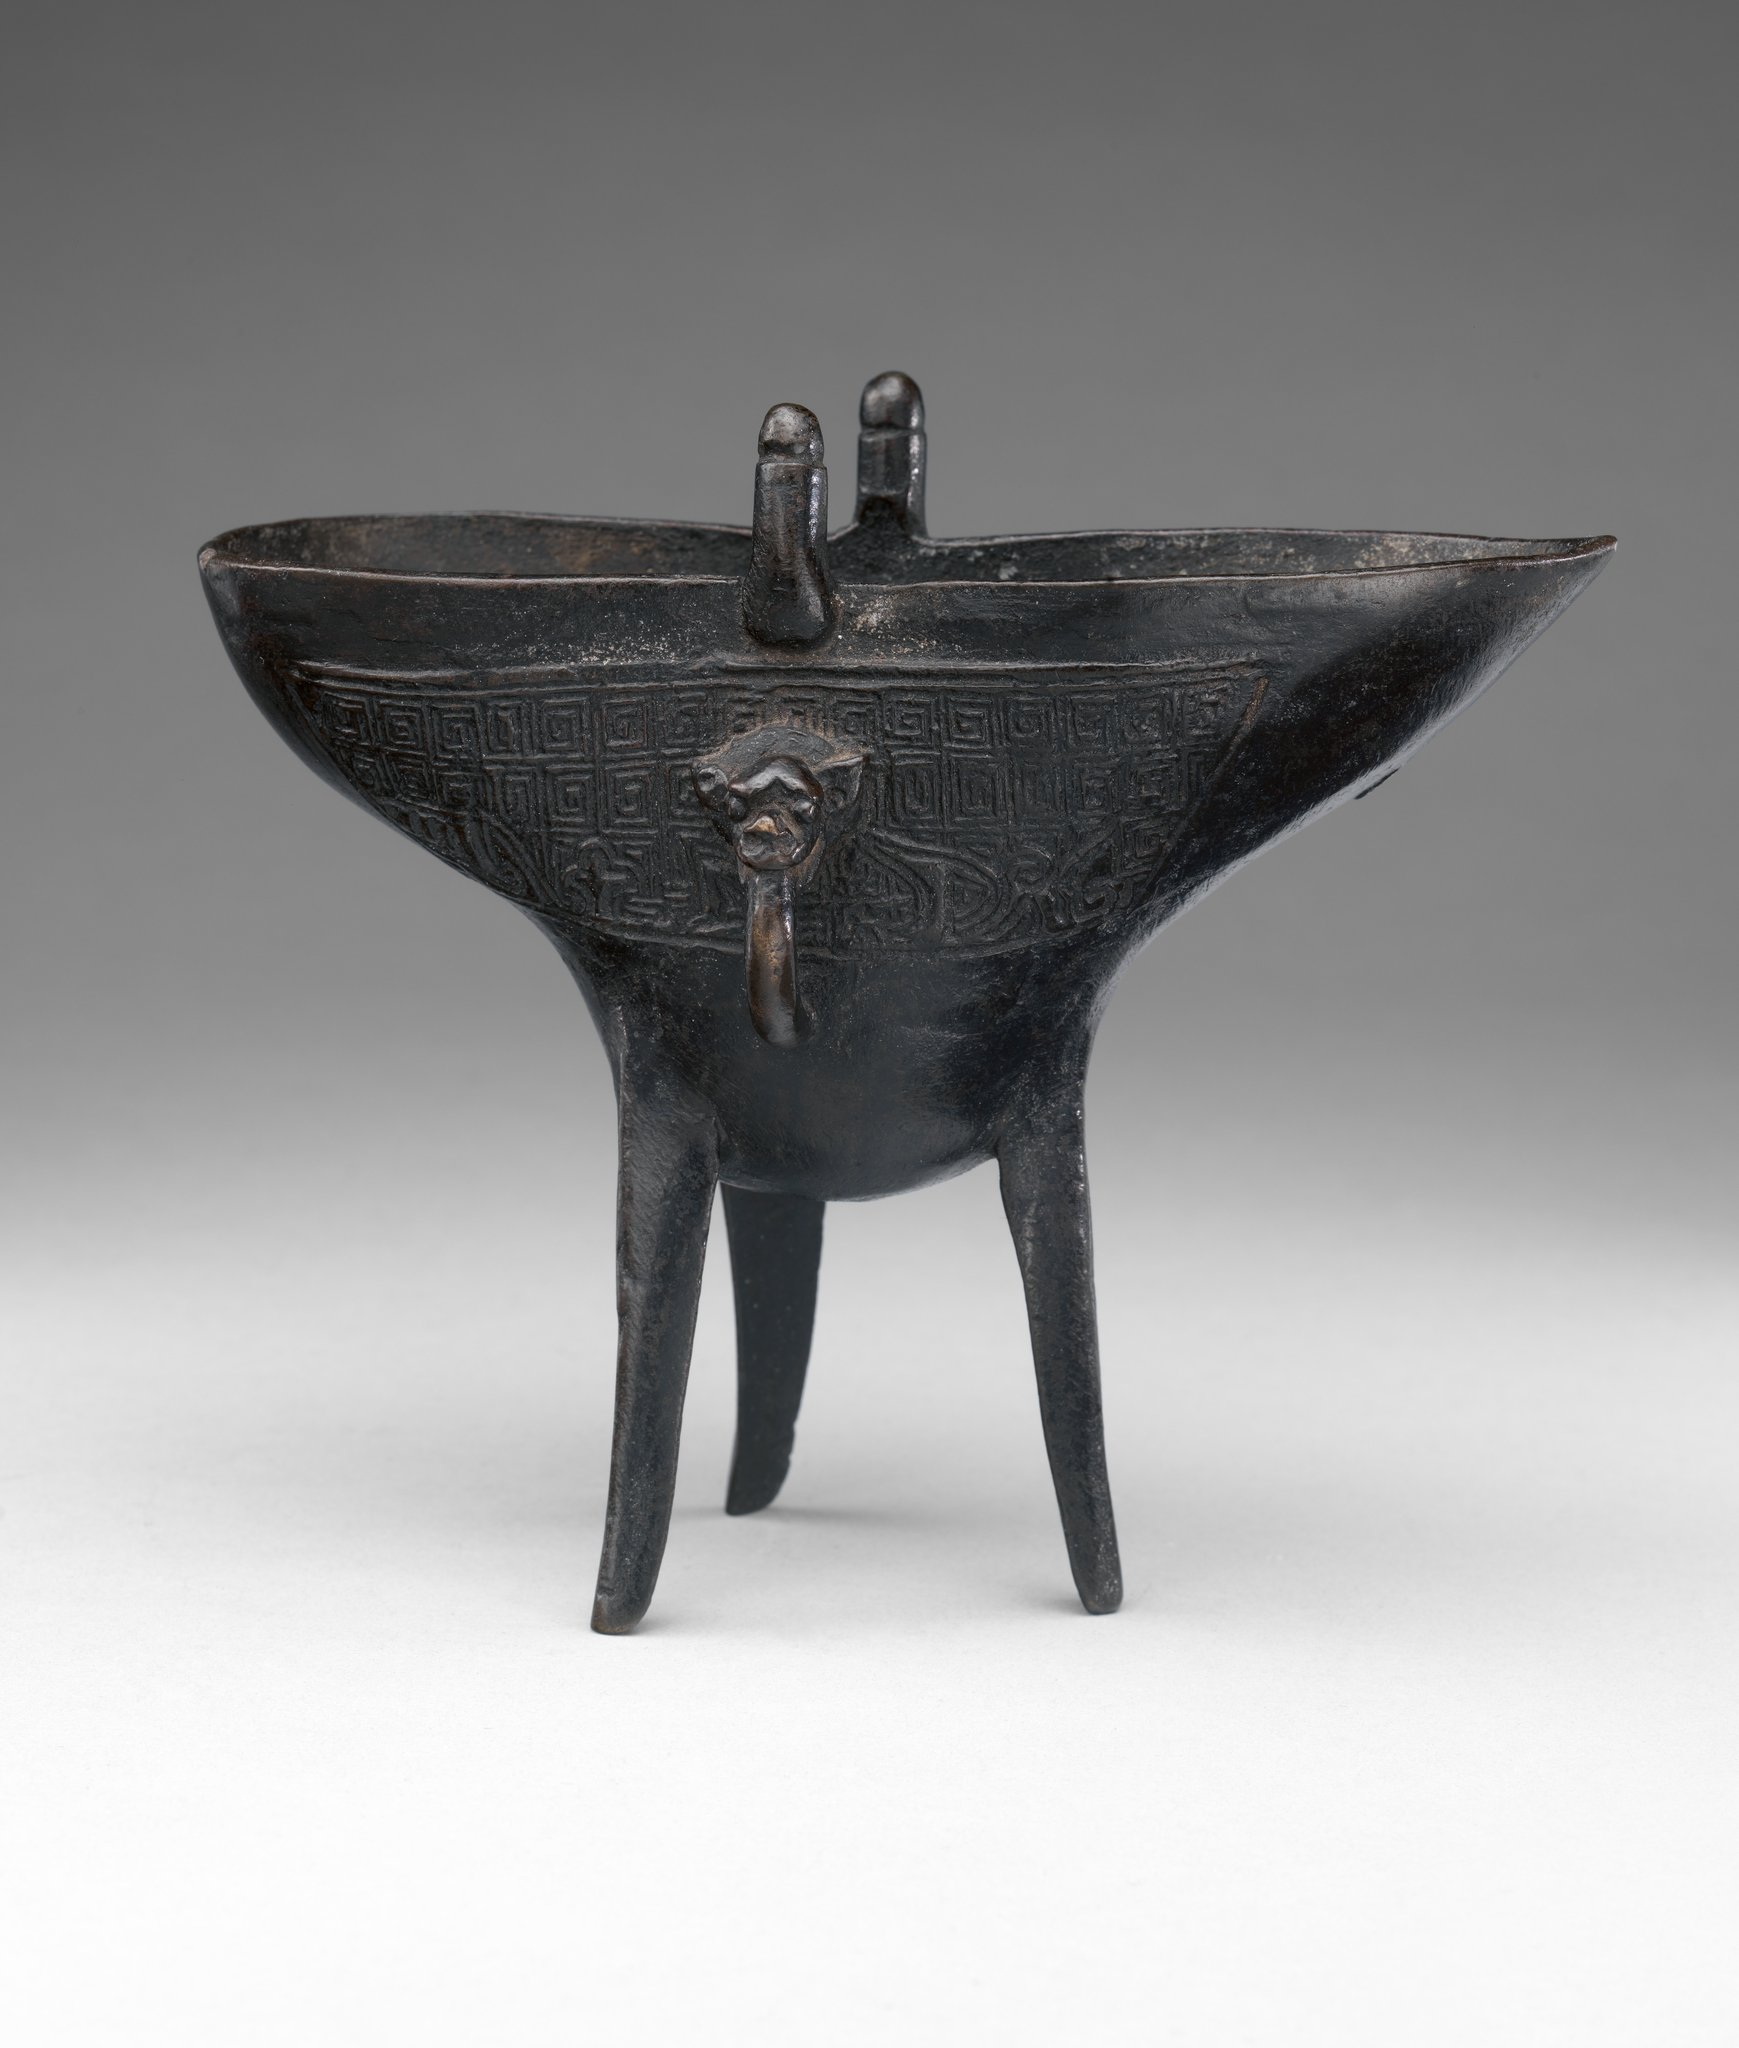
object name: wine cup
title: Wine Cup of Archaistic Design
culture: chinese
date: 1368-1644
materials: bronze